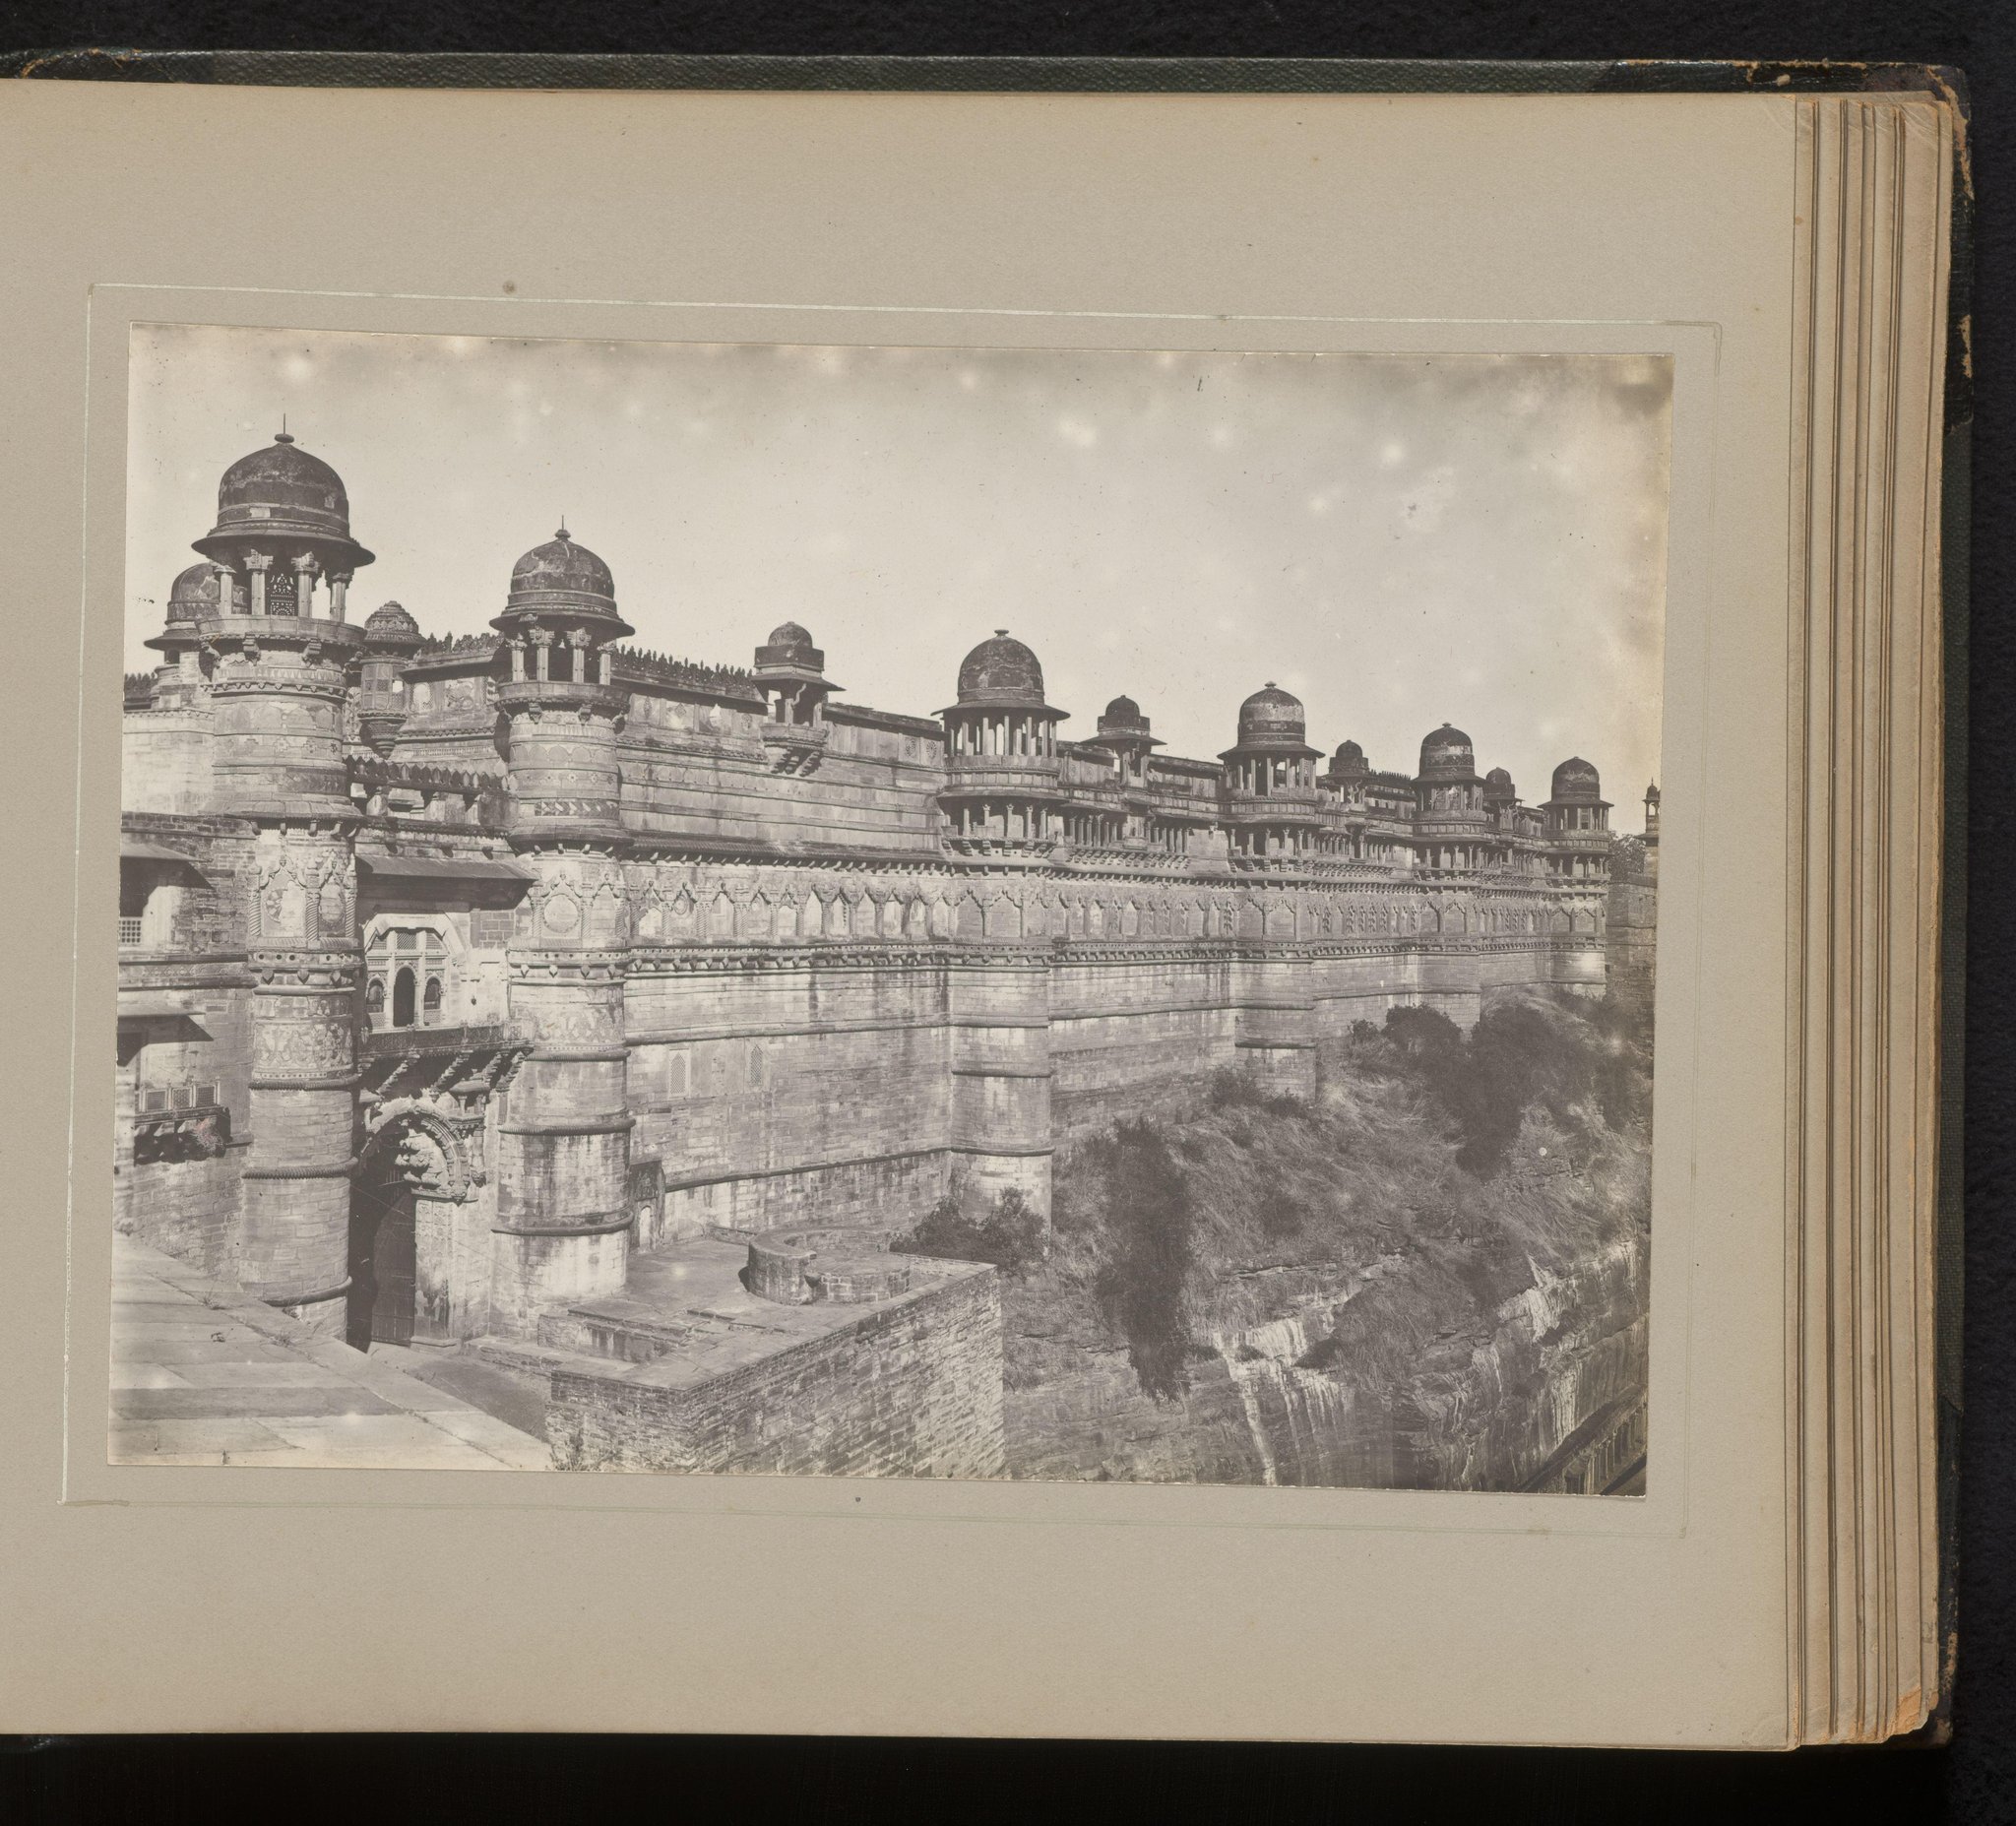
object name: page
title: Paleis van Raja Mansingh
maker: k.h. mawal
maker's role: fotograaf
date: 1900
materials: photographic support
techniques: gelatin silver print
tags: palace